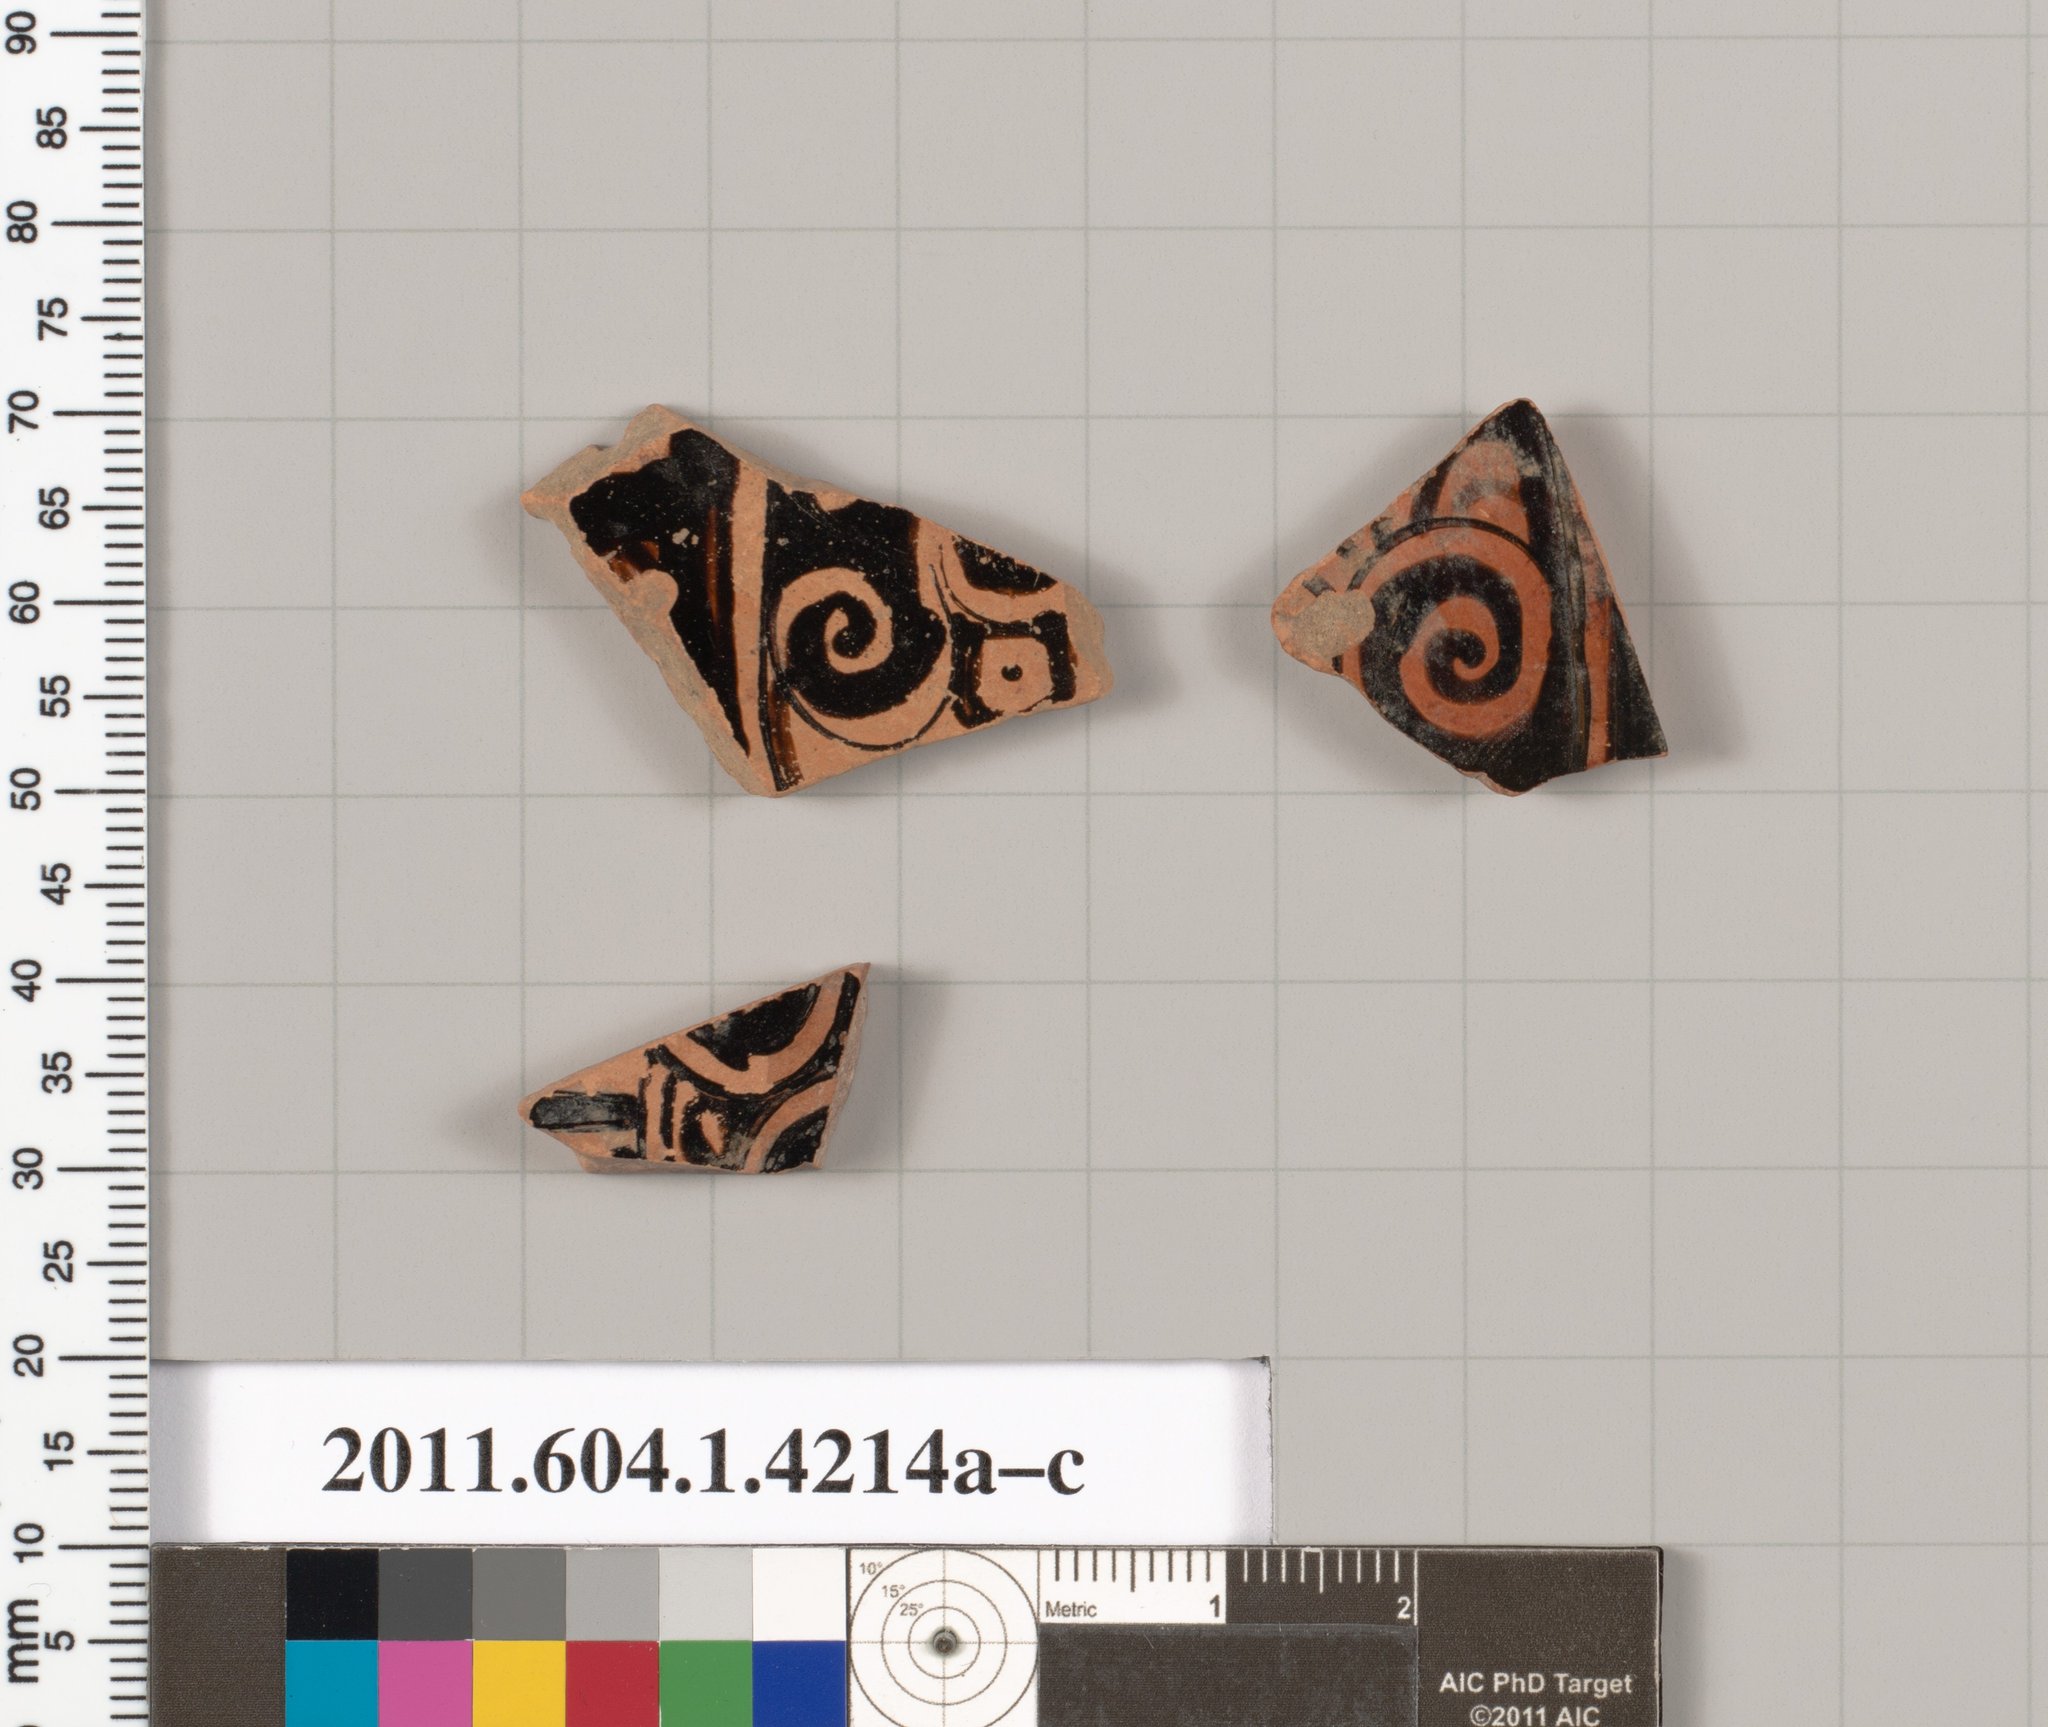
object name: kylix fragment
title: Terracotta fragments of kylikes (drinking cups)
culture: greek, attic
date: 500-451 BCE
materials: terracotta